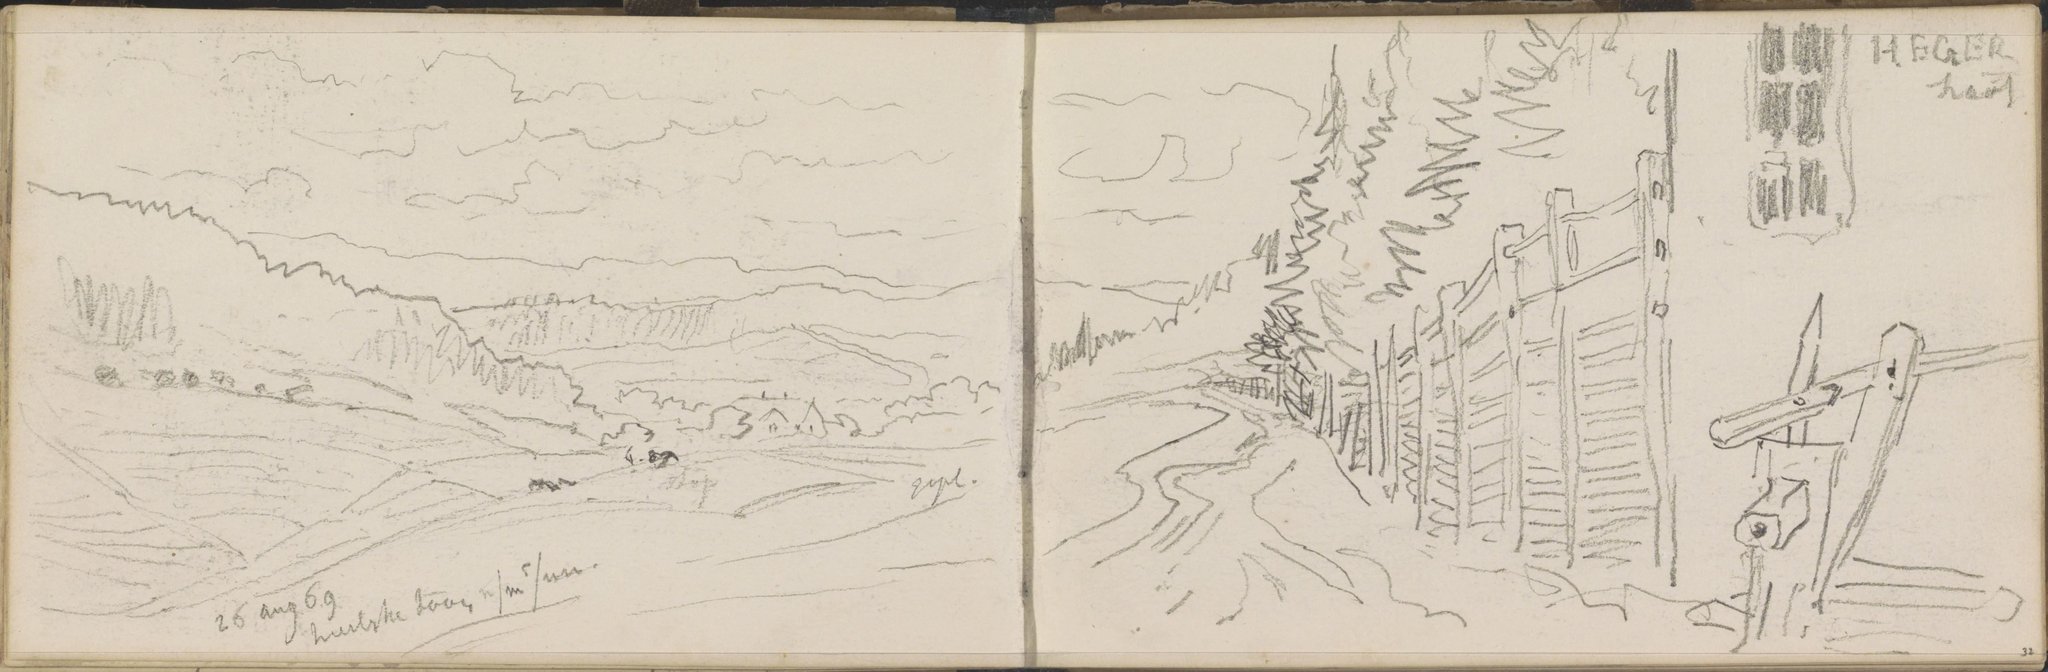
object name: sketchbook leaf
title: Park van Metternich met een jachthut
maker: johannes tavenraat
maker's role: draughtsman, painter, print maker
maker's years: 1809-1881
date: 1808-1869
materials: paper, pencil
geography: marienbad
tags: low hill country, hunting-seat, hunting lodge, 'rendez-vous de chasse', 'jagdschloss', marienbad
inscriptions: date and inscription: ‘26 aug 69/ heerlijke toon n/m 5/uur/ HEGER/ h[...]’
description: Blad 31 verso en 32 recto uit een schetsboek met 48 bladen.